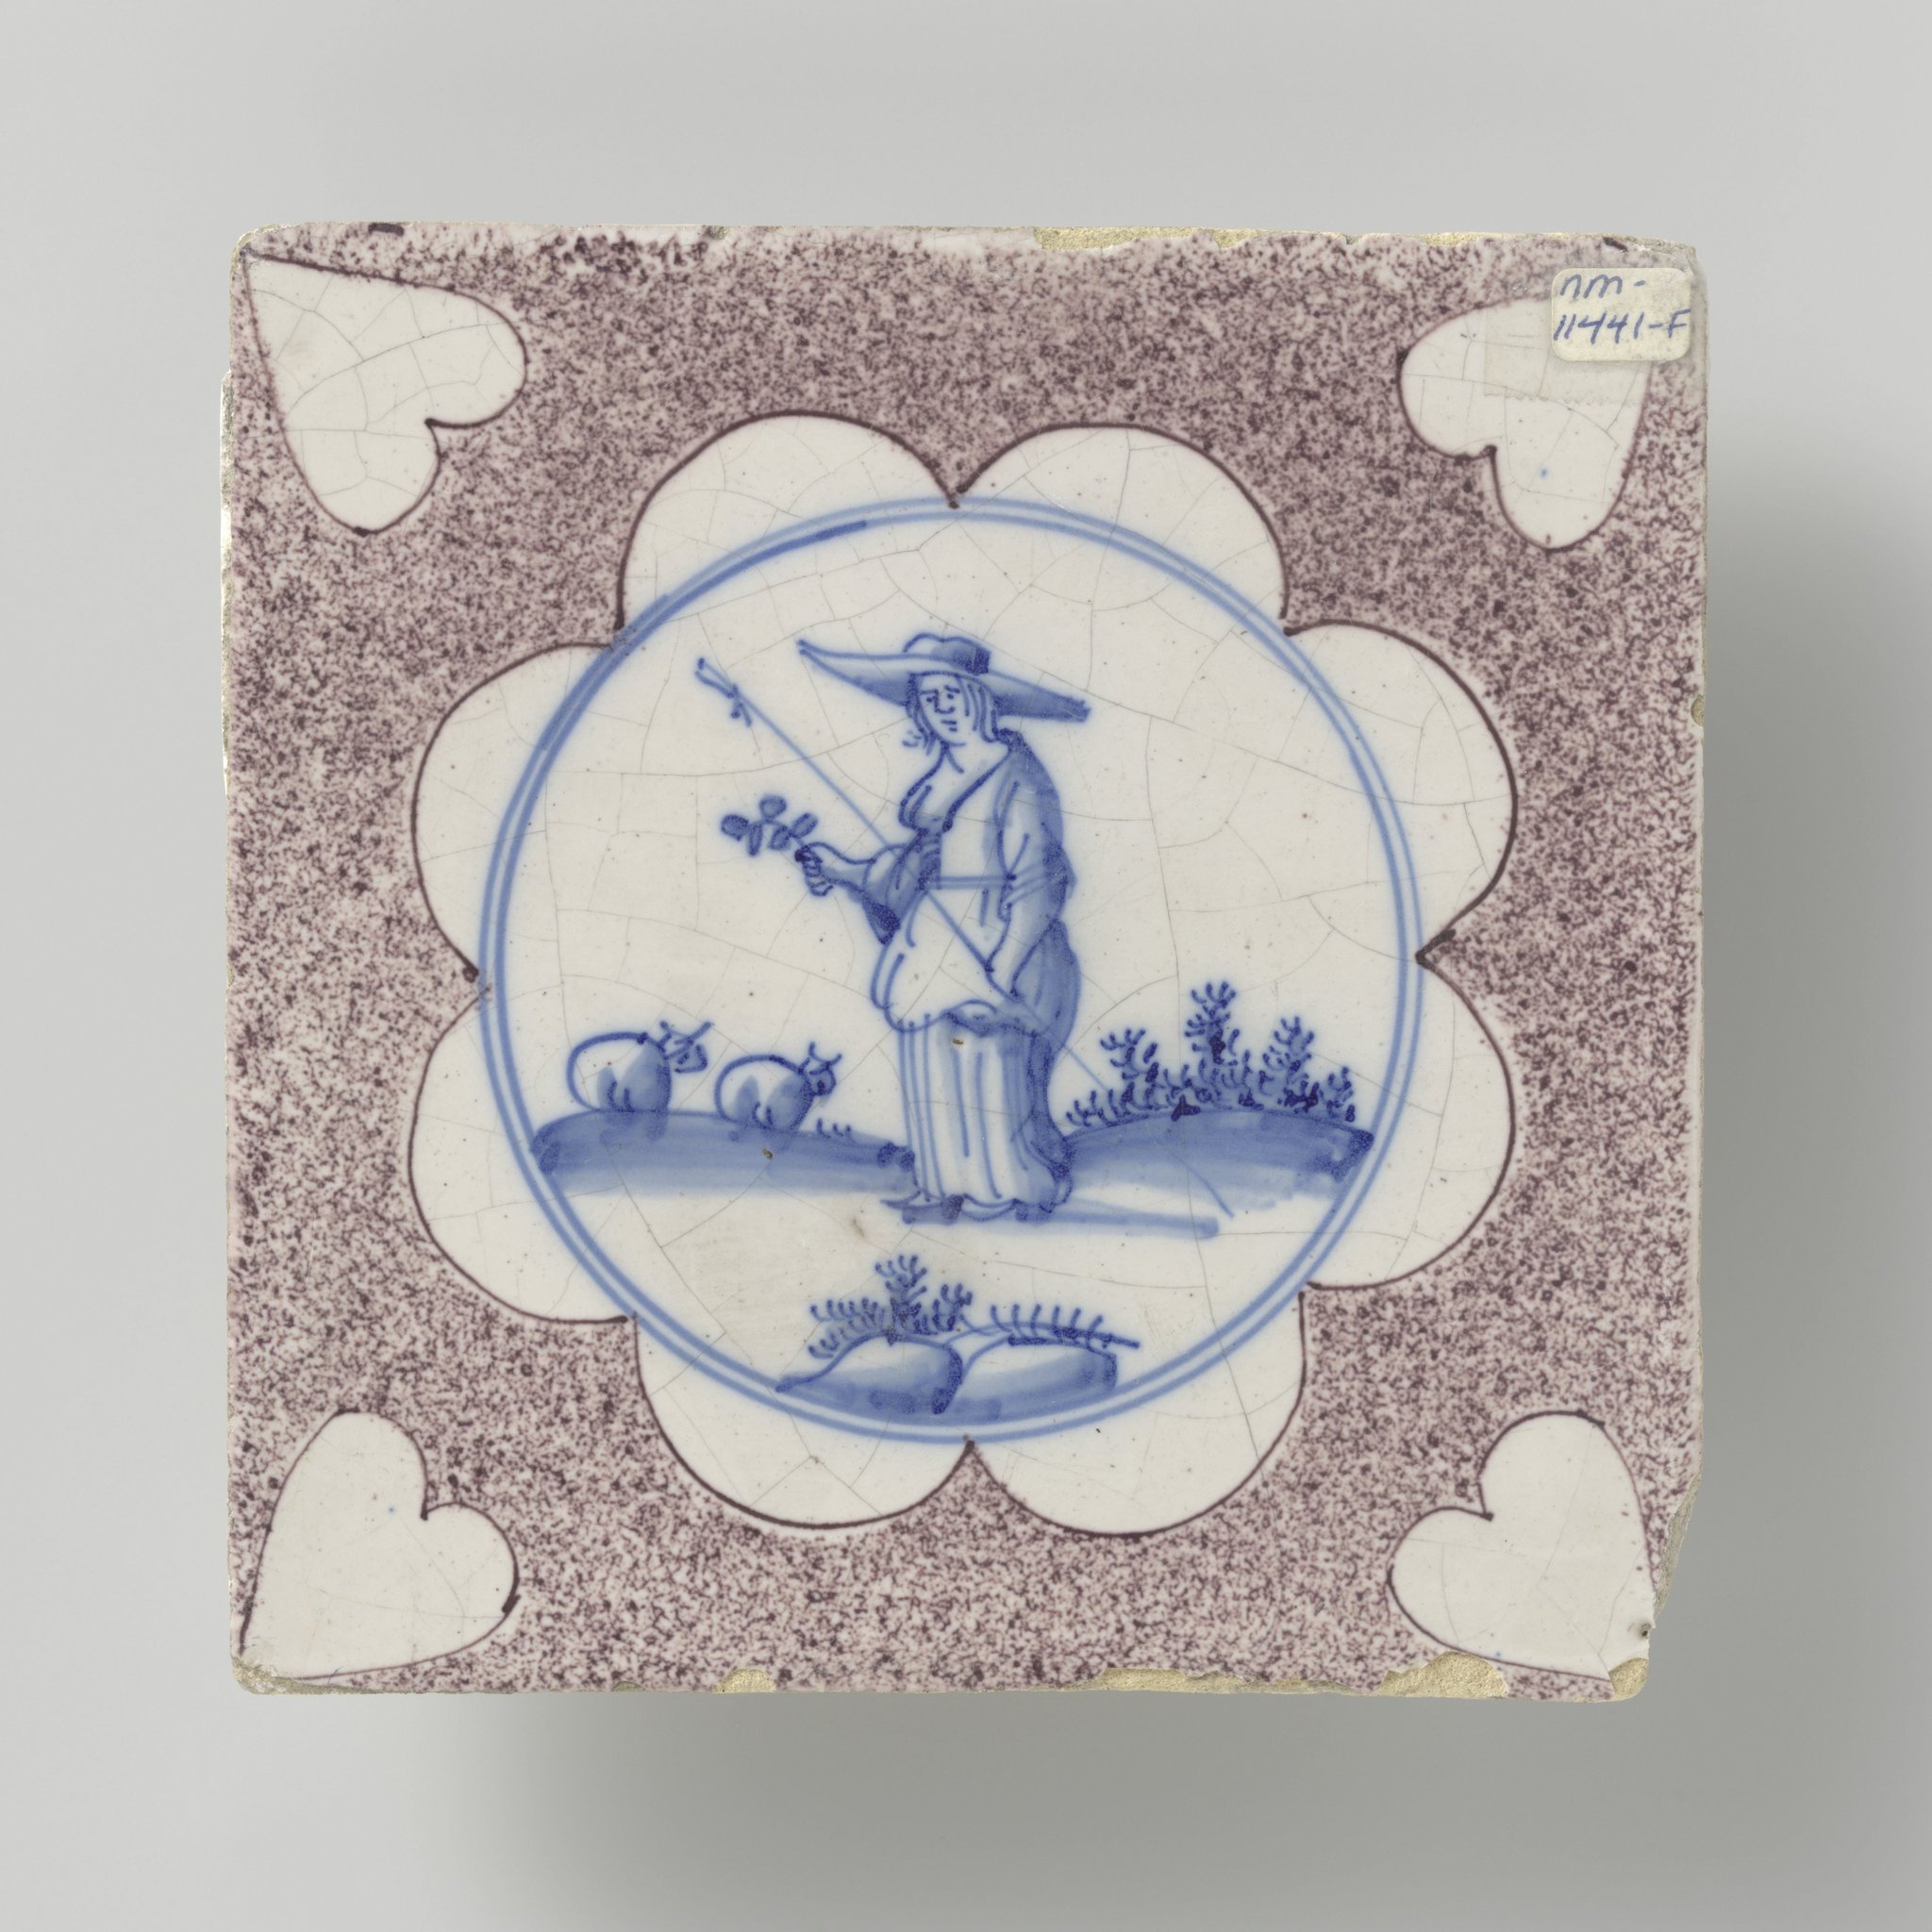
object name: tile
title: Tegel met een blauw geschilderde pastorale voorstelling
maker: Anonymous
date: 1680-1725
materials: earthenware, glaze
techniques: maiolica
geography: netherlands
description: Tegel met een blauw geschilderde pastorale voorstelling binnen een geschulpte cirkel omgeven door paars spatwerk. In de hoeken, een uitgespaarde hartvorm. Behorend bij een groep van 23 tegels.